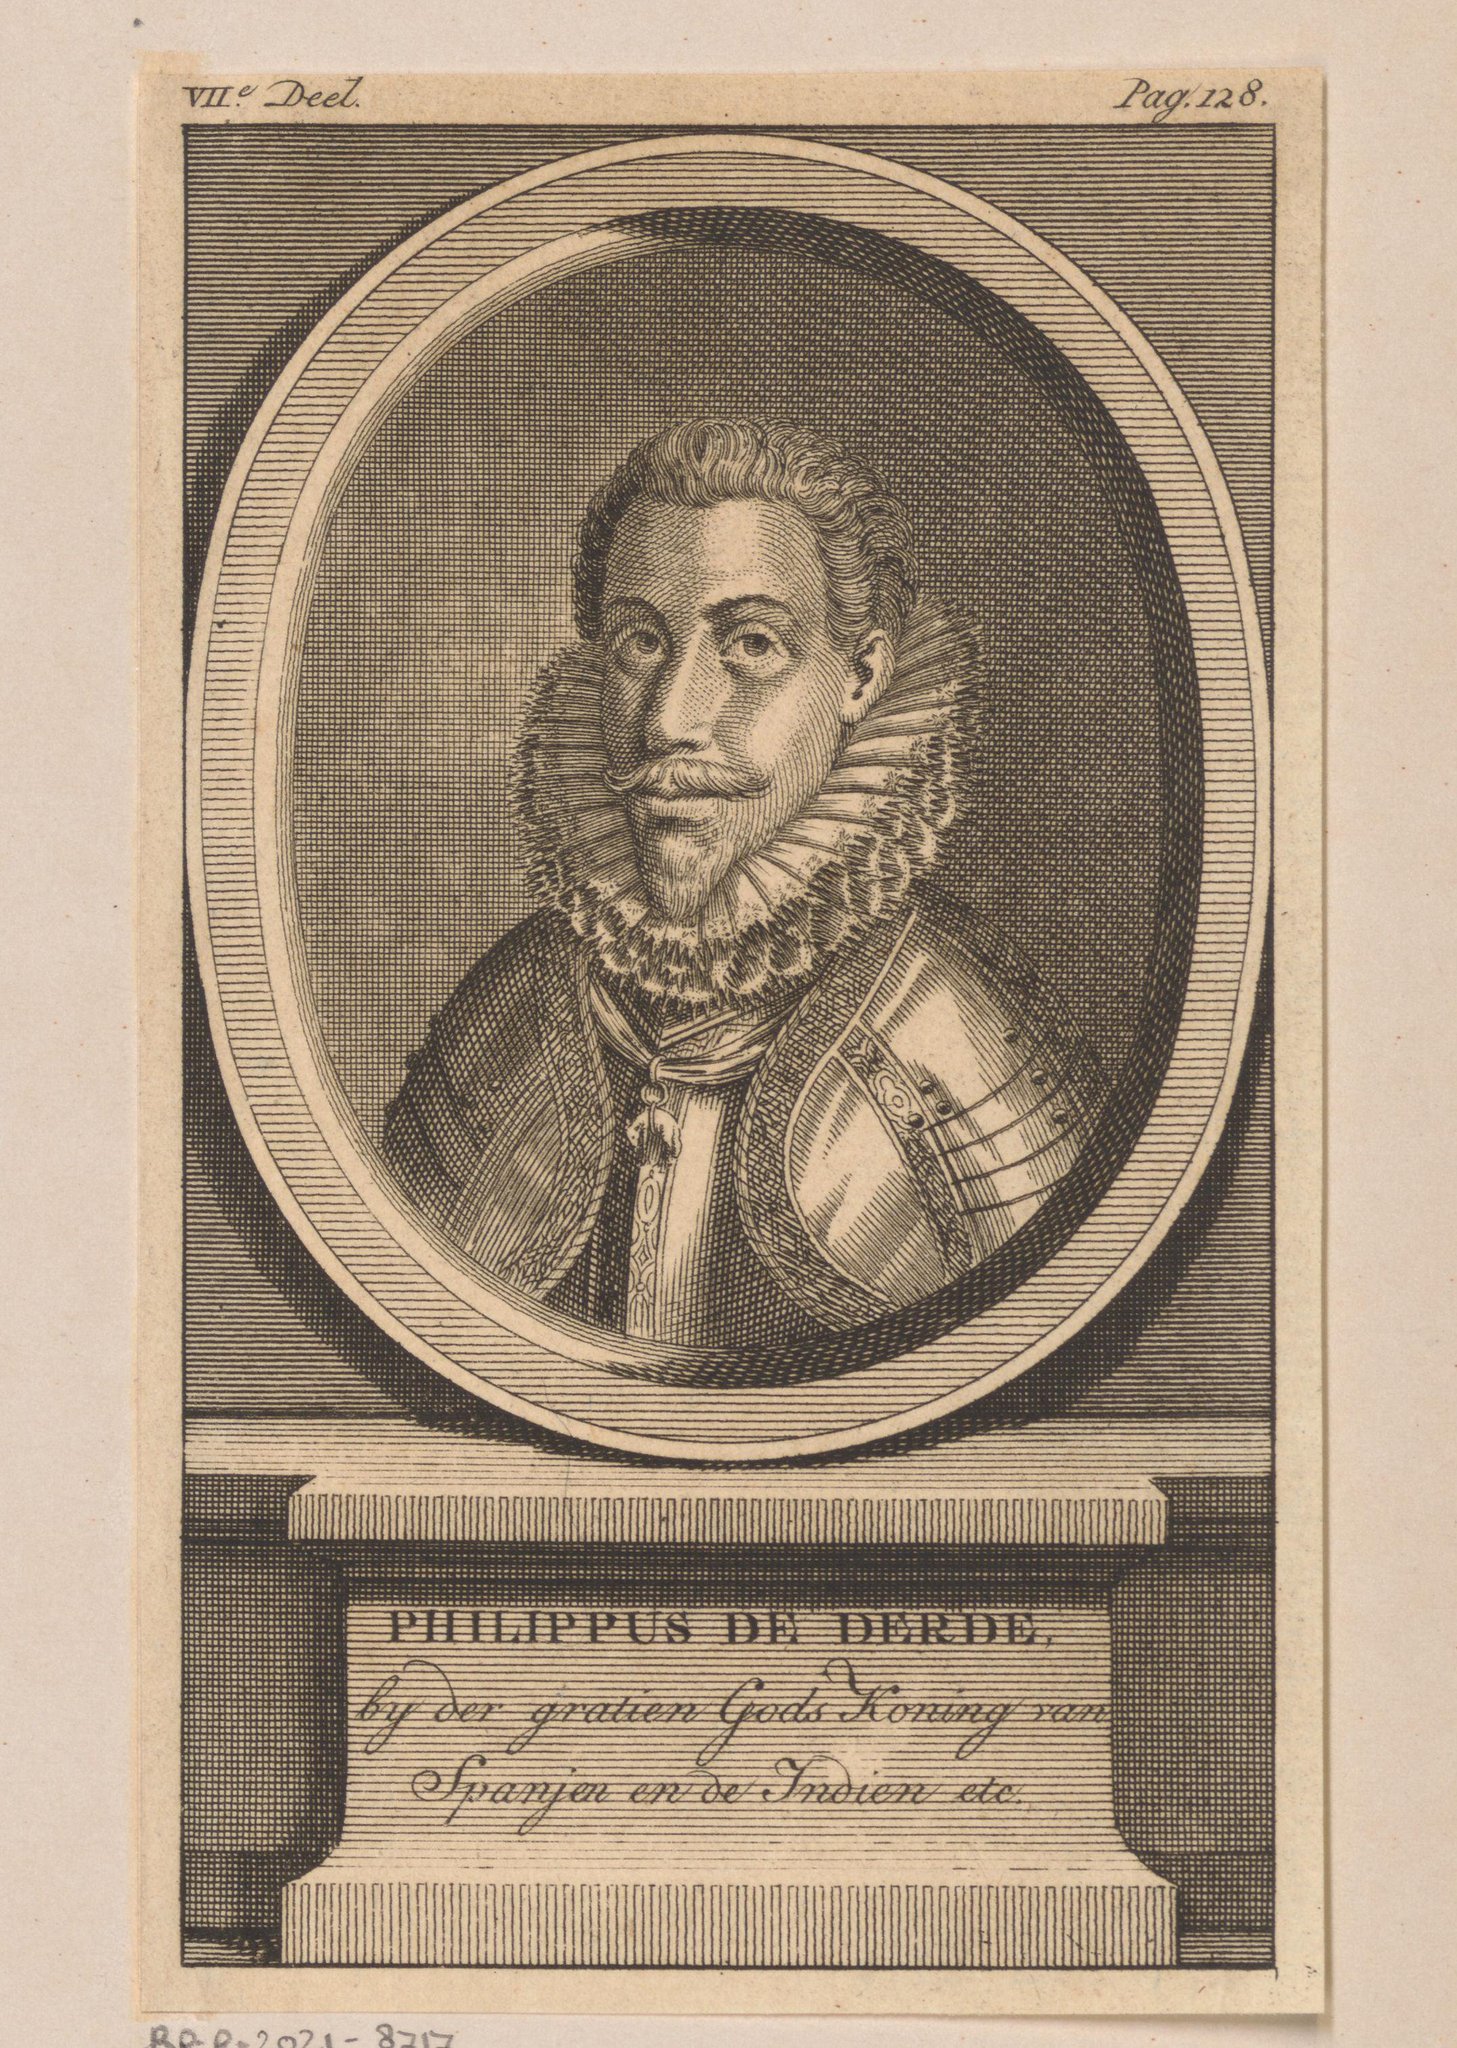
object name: print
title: Portret van Filips III, koning van Spanje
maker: Anonymous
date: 1650-1799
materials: paper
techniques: engraving, etching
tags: filips iii (koning van spanje), adult man, historical persons, knighthood order of the golden fleece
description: Linksboven: VIIe Deel. Rechtsboven: Pag. 128.